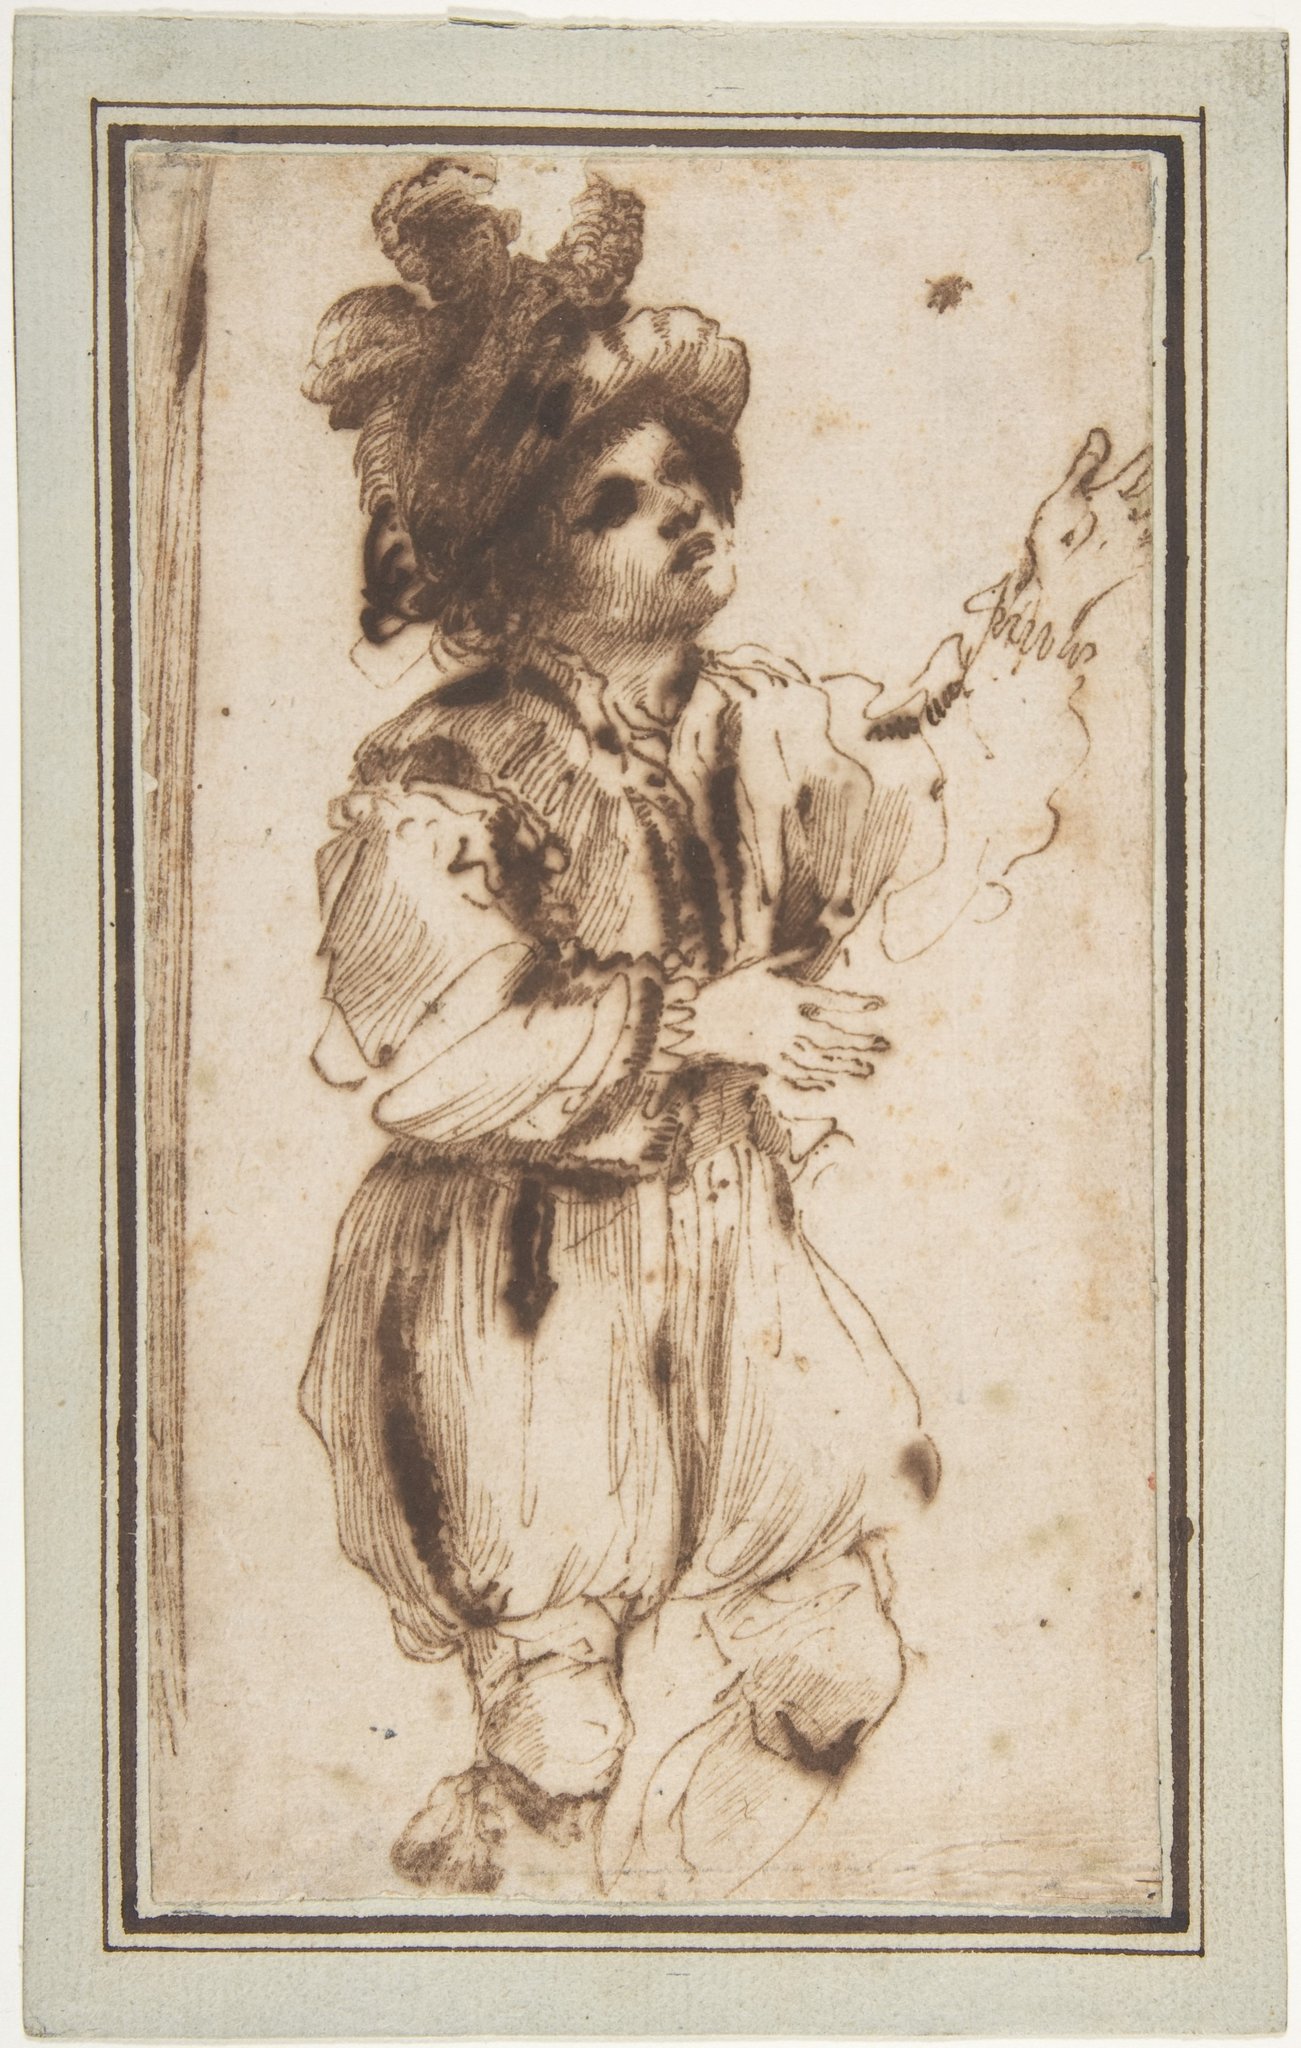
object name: drawing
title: Boy Chasing a Butterfly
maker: guercino (giovanni francesco barbieri)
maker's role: artist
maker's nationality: italian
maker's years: 1591-1666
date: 1591-1666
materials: ink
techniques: pen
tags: boys,butterflies